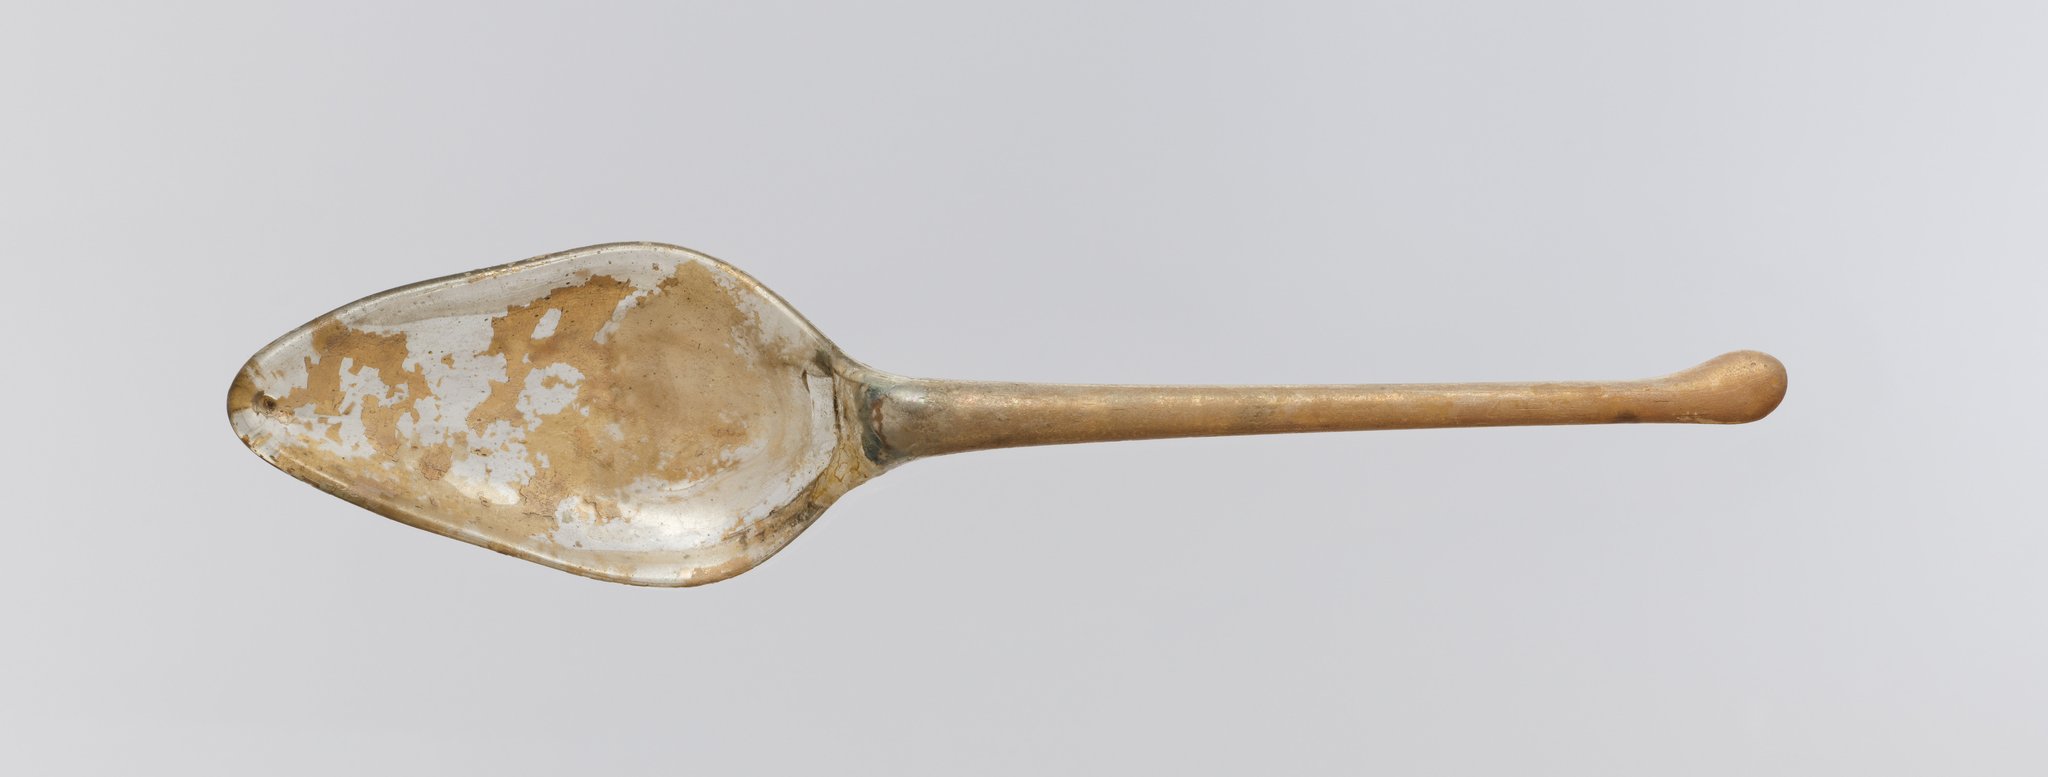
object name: spoon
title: Glass spoon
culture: roman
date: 301-400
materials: glass